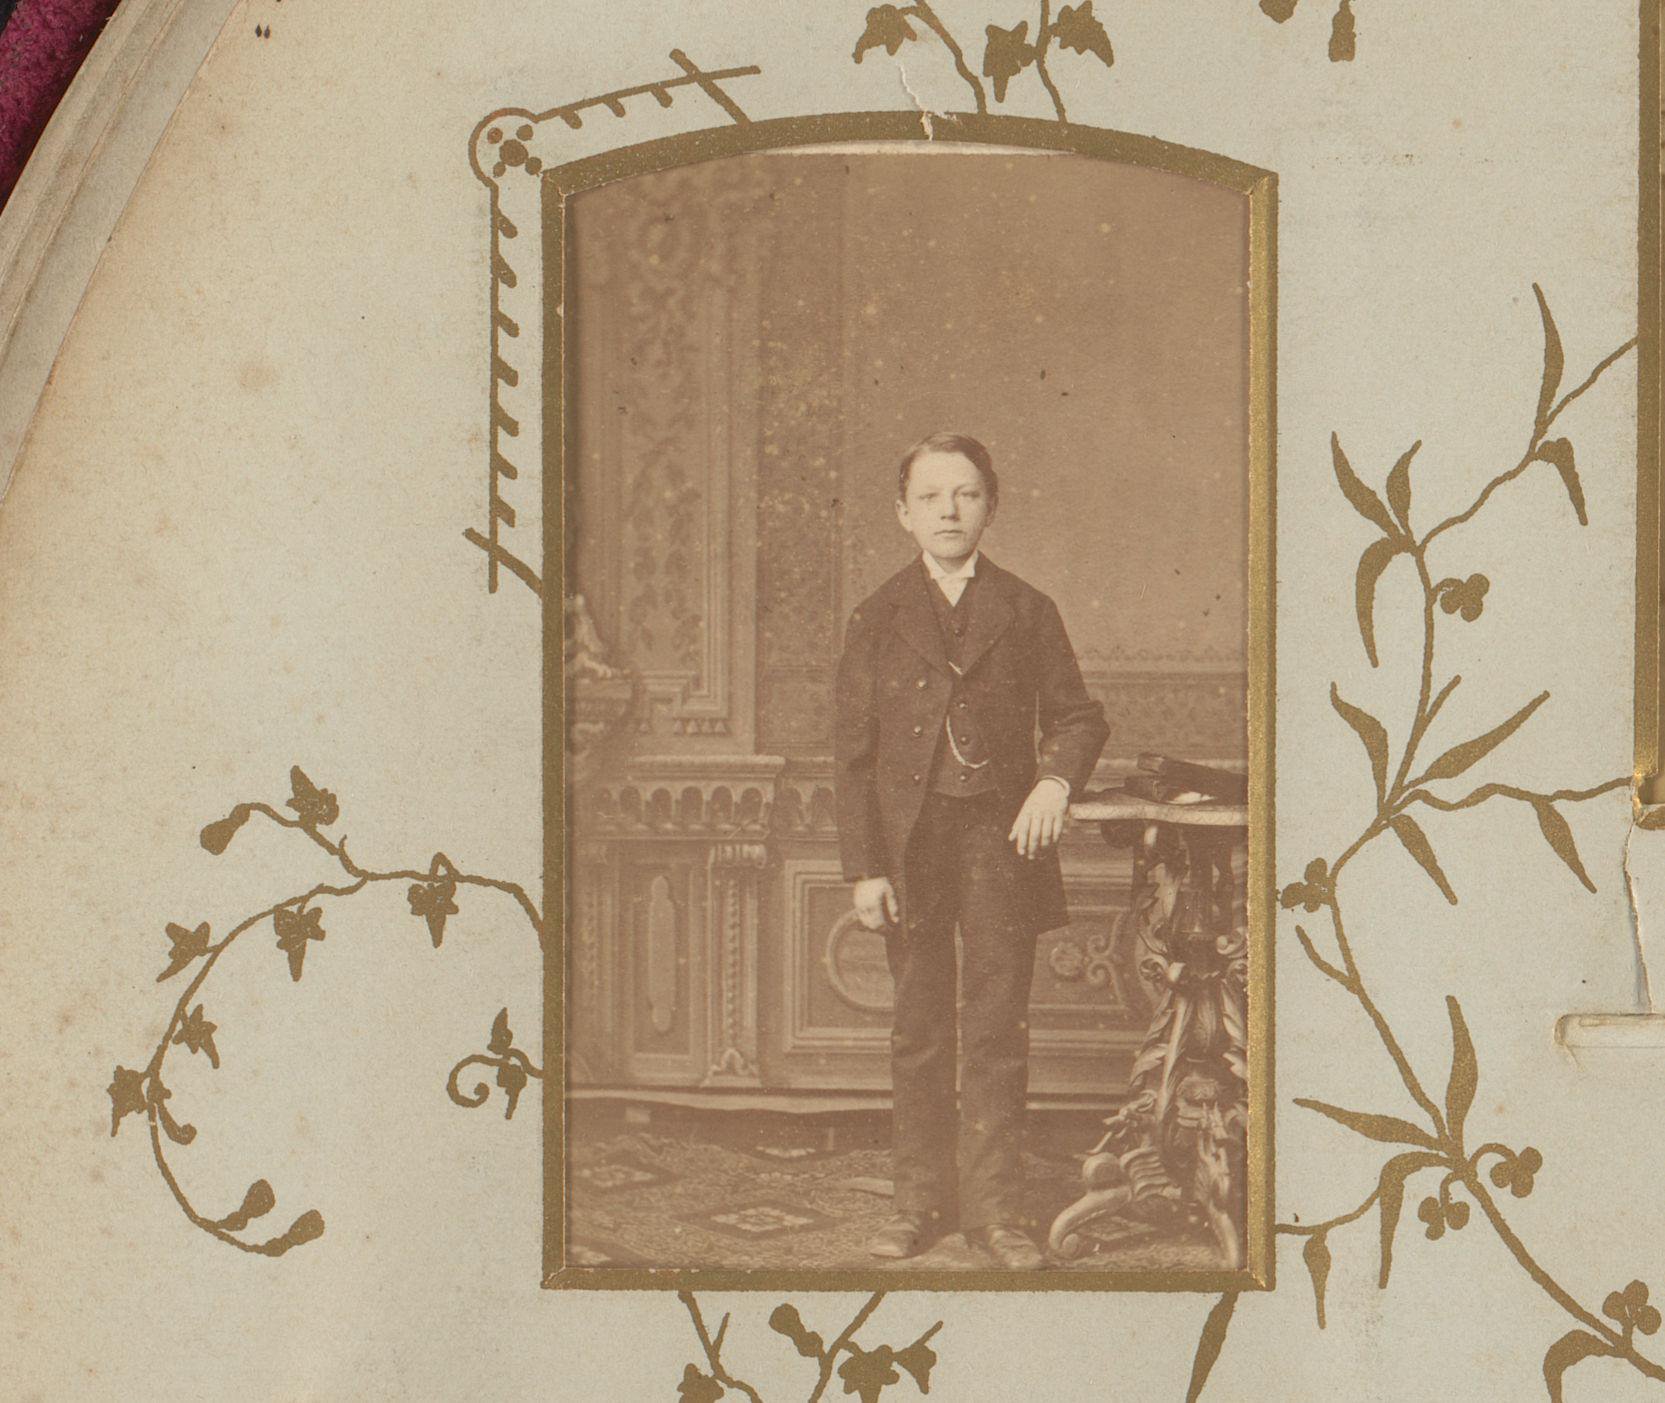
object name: album leaf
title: Portret van een jongen in pak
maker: ernst ulbrich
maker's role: fotograaf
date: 1860-1900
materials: cardboard, photographic support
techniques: albumen print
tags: boy (child between toddler and youth), historical persons